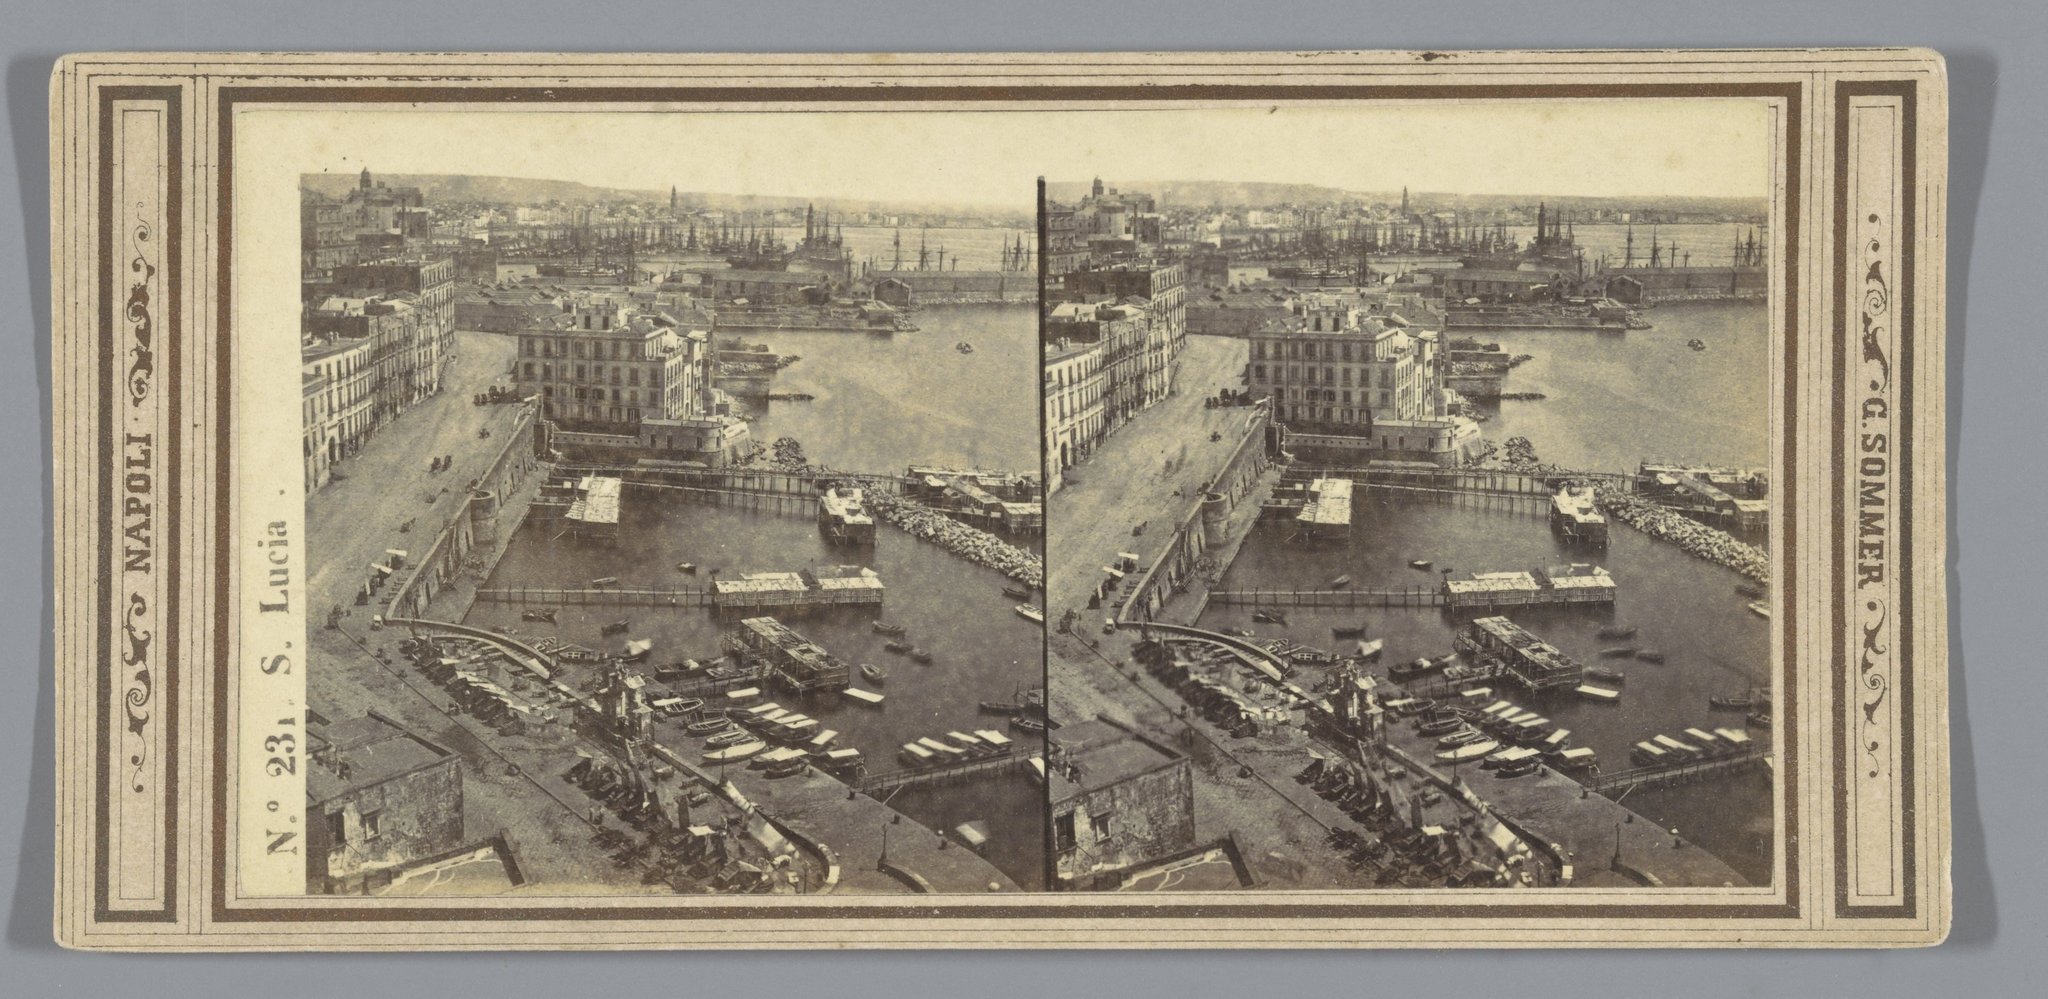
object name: stereograph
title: S. Lucia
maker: giorgio sommer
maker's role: fotograaf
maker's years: 1834-1914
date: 1860-1880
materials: cardboard, photographic support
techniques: albumen print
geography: naples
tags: city-view, and landscape with man-made constructions, naples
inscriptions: number: ‘K 23.’, number: ‘No. 231’